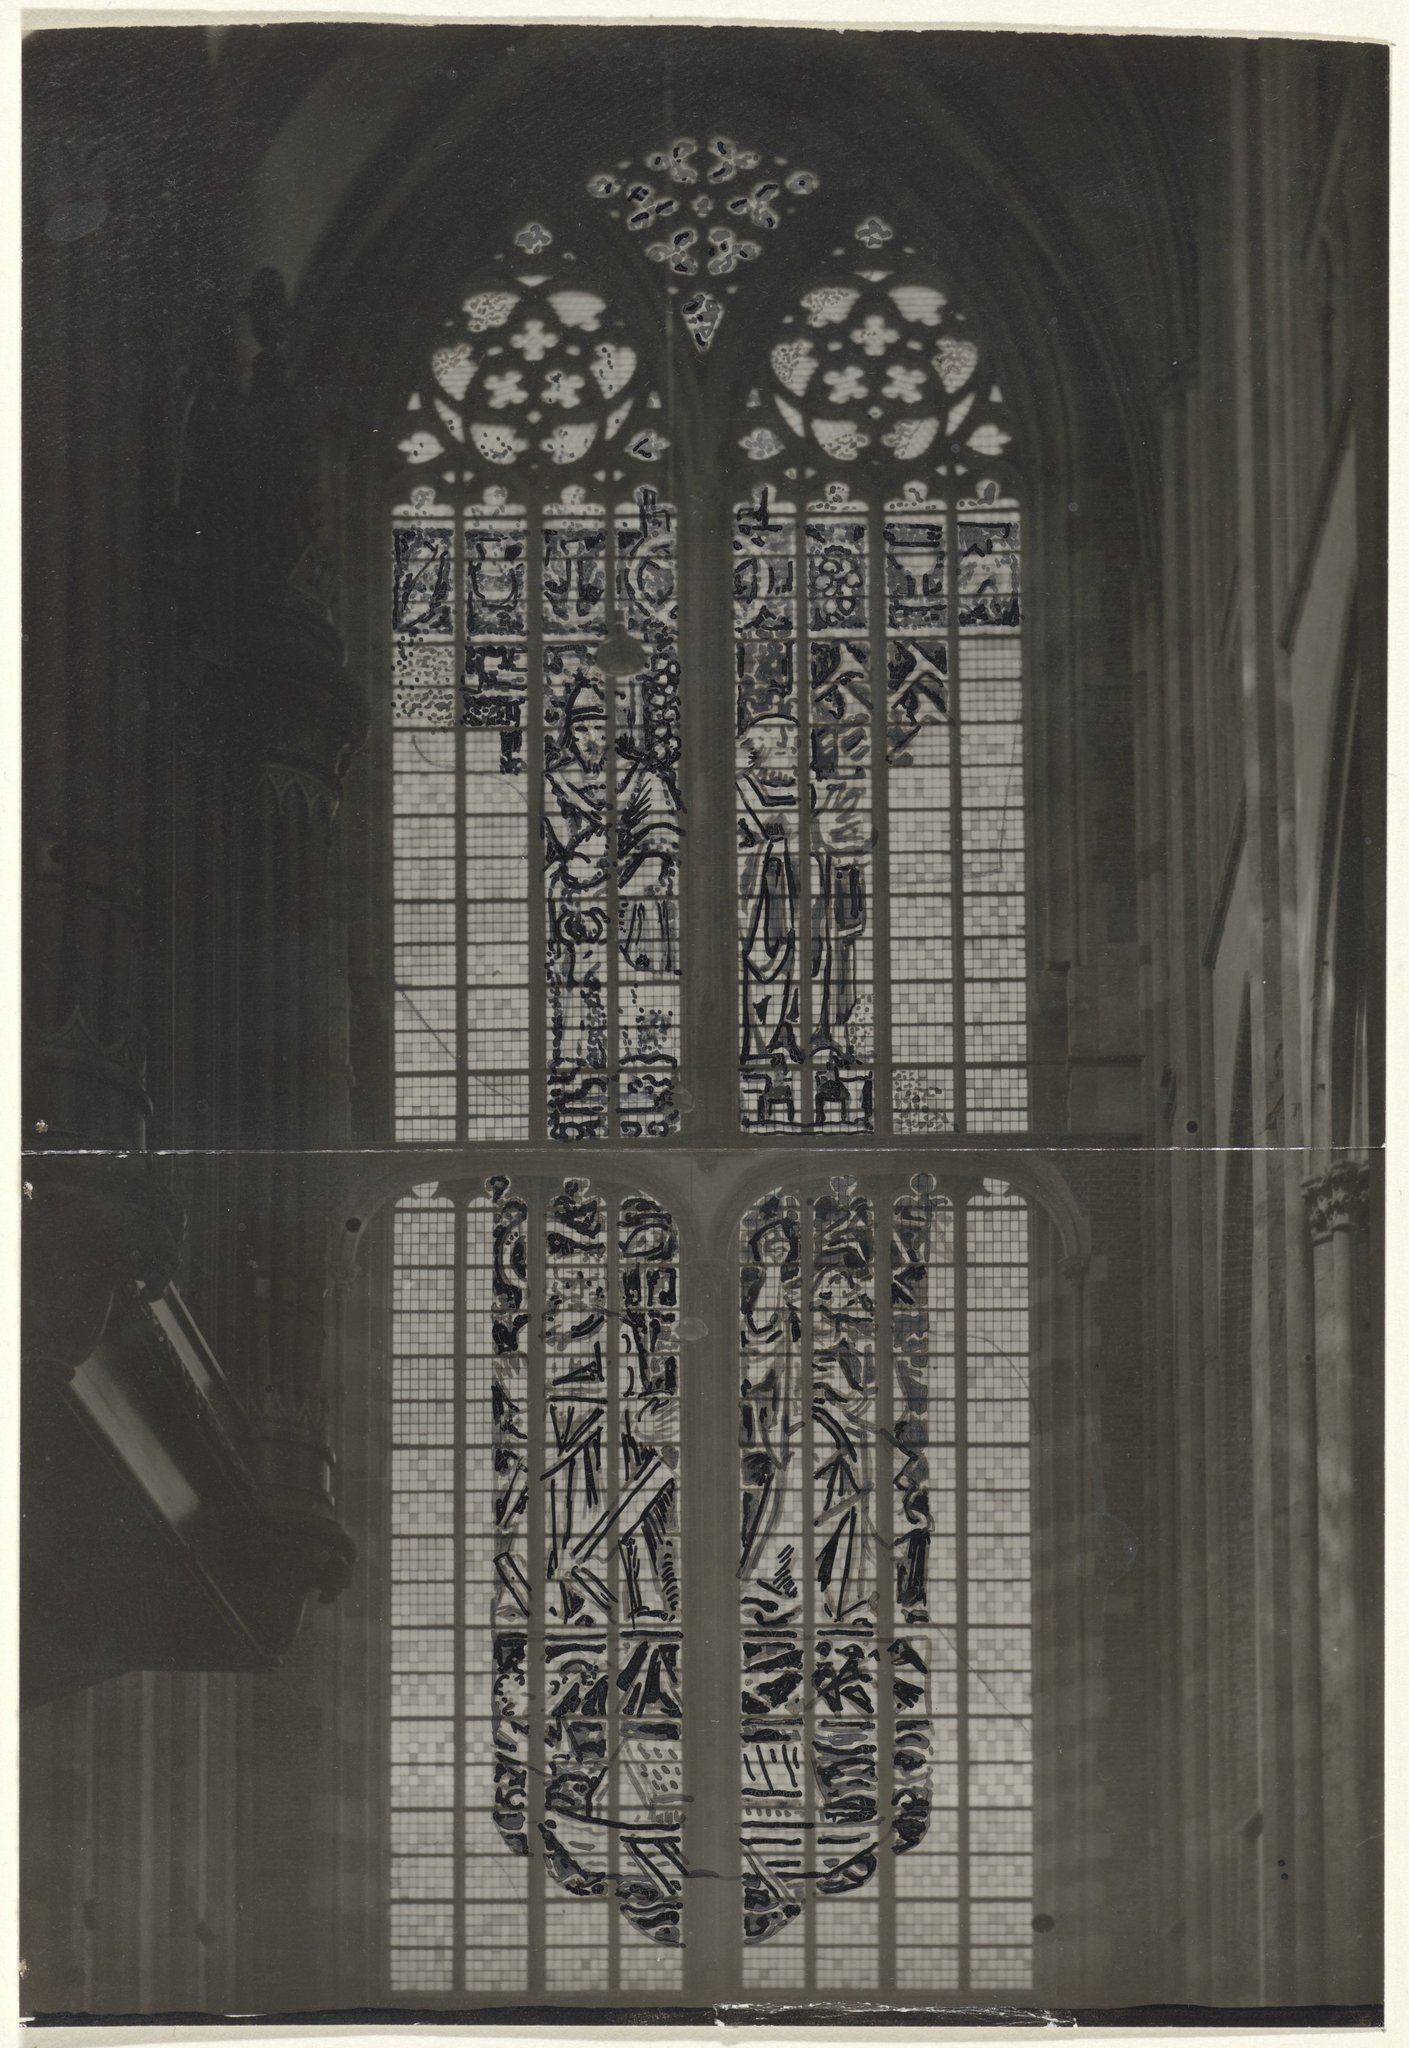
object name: photograph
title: Ontwerp voor raam in het Noordertransept in de Dom te Utrecht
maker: richard nicolaüs roland holst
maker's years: 1868-1938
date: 1878-1938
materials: ink, paper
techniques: pen, photography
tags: church-window, e.g. rose-window, interior of church, utrecht